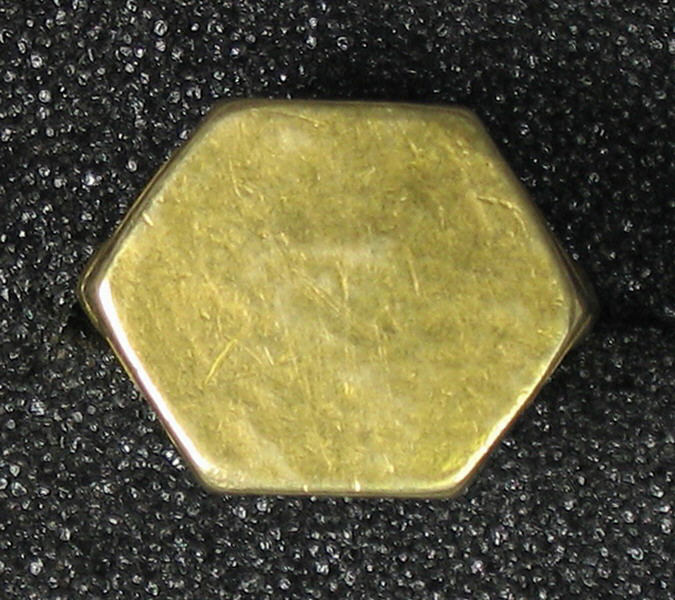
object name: ring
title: Ring with Hexagonal Bezel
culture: indonesian, central java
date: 701-1200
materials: gold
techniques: casting